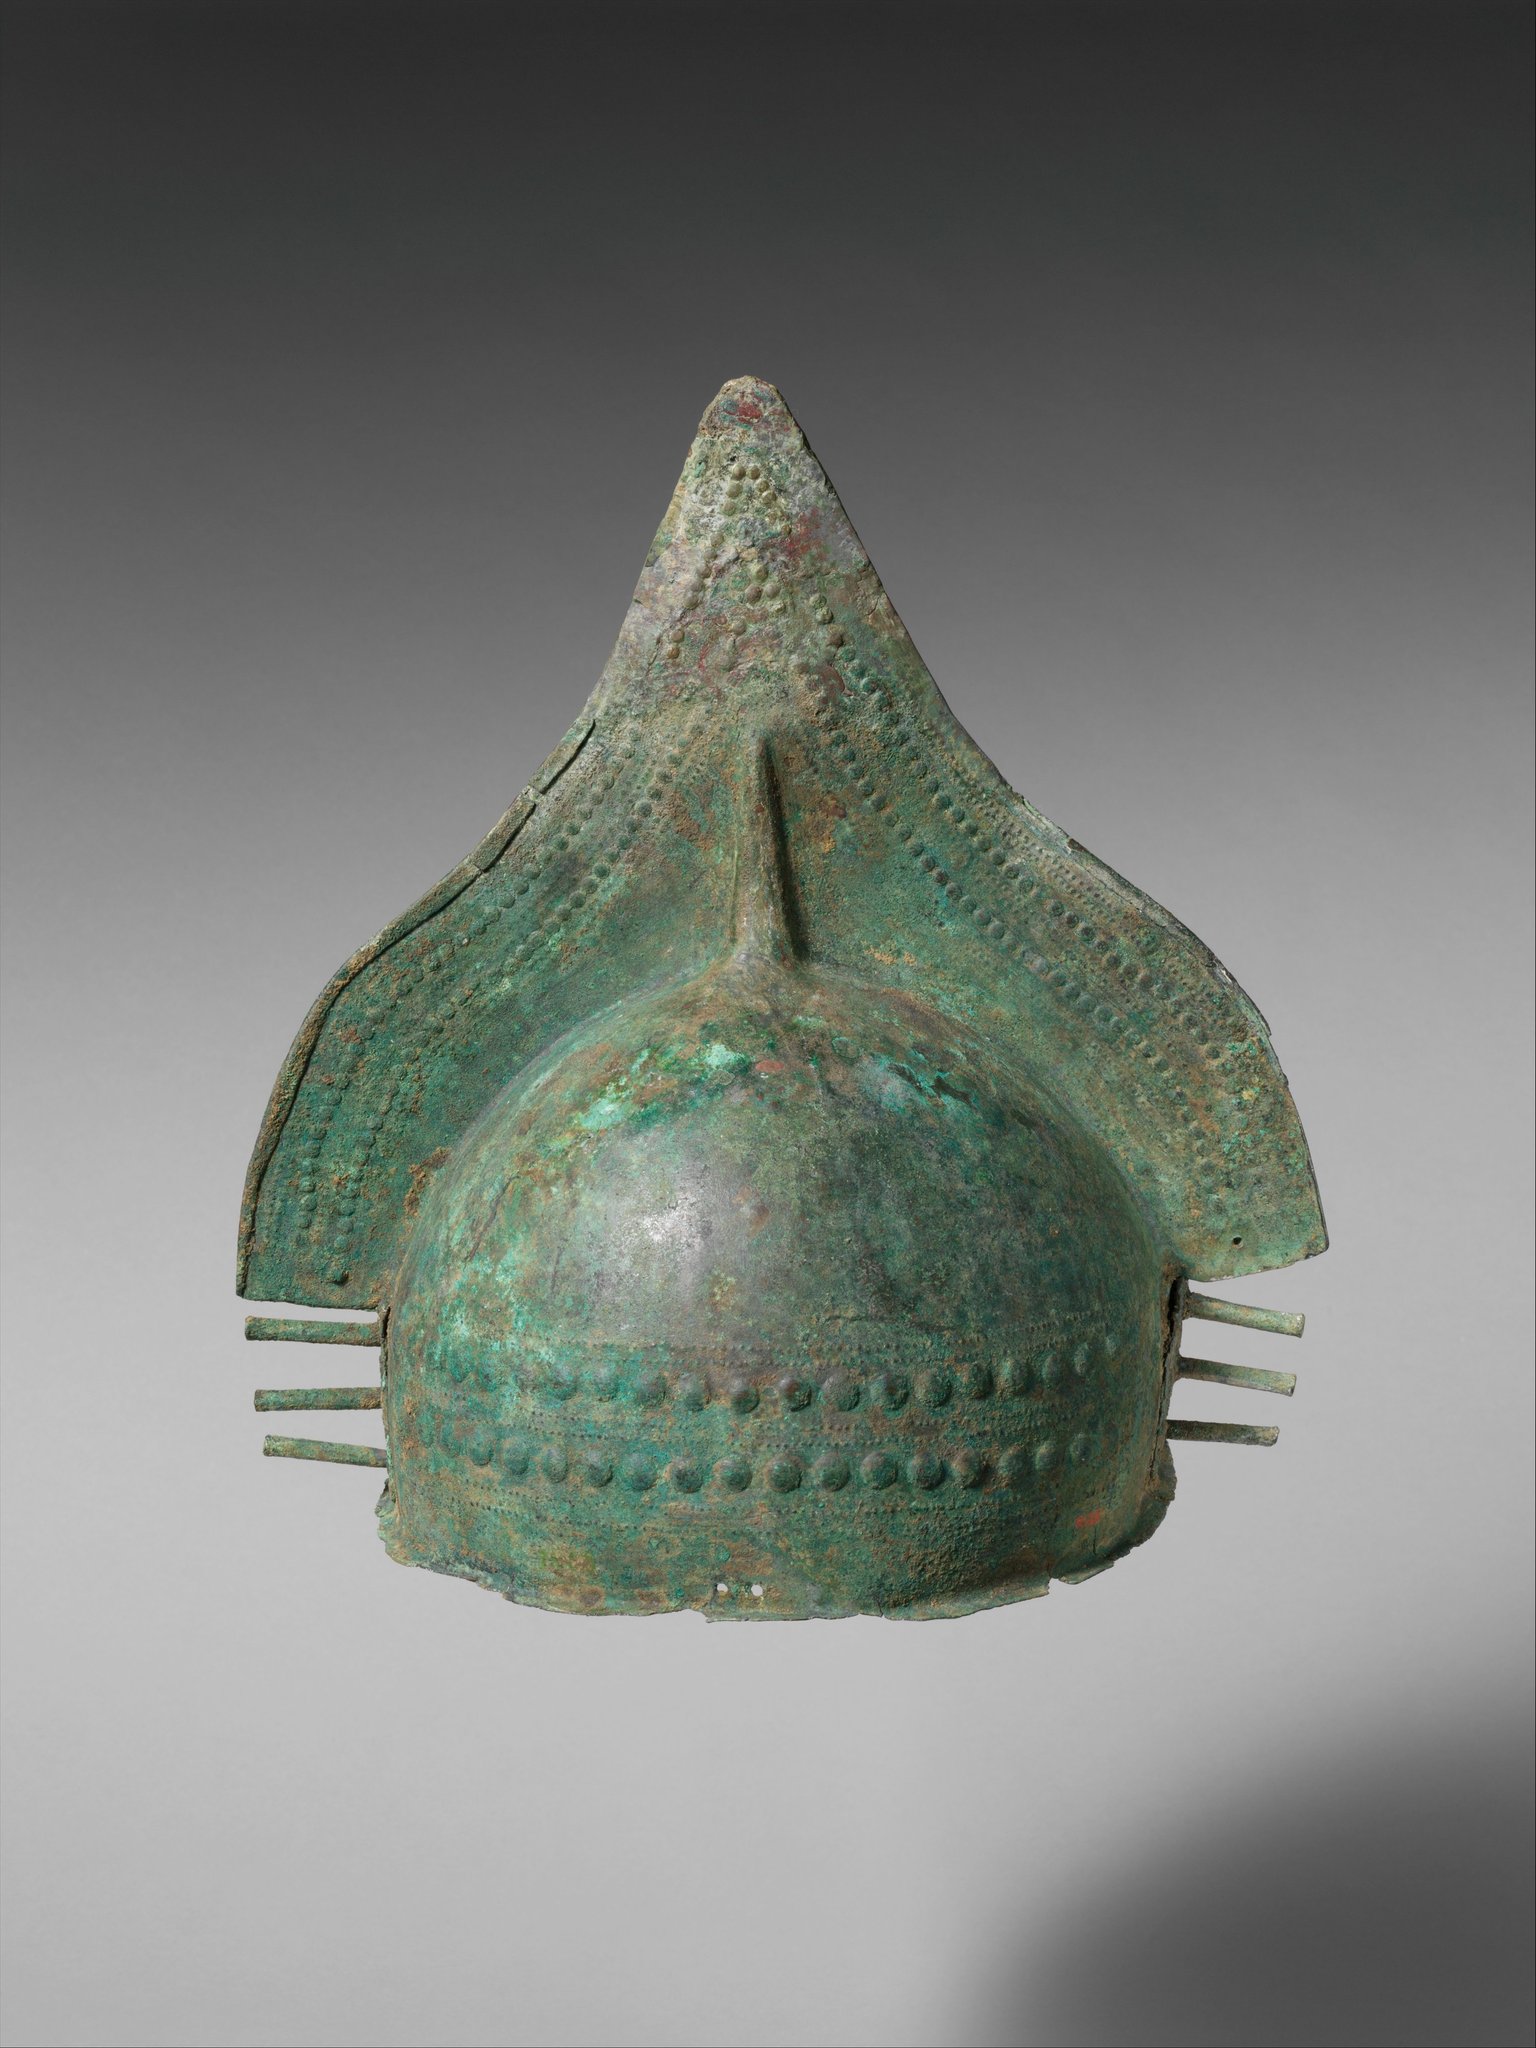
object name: helmet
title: Bronze crested helmet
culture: villanovan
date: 900-801 BCE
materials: bronze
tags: helmets